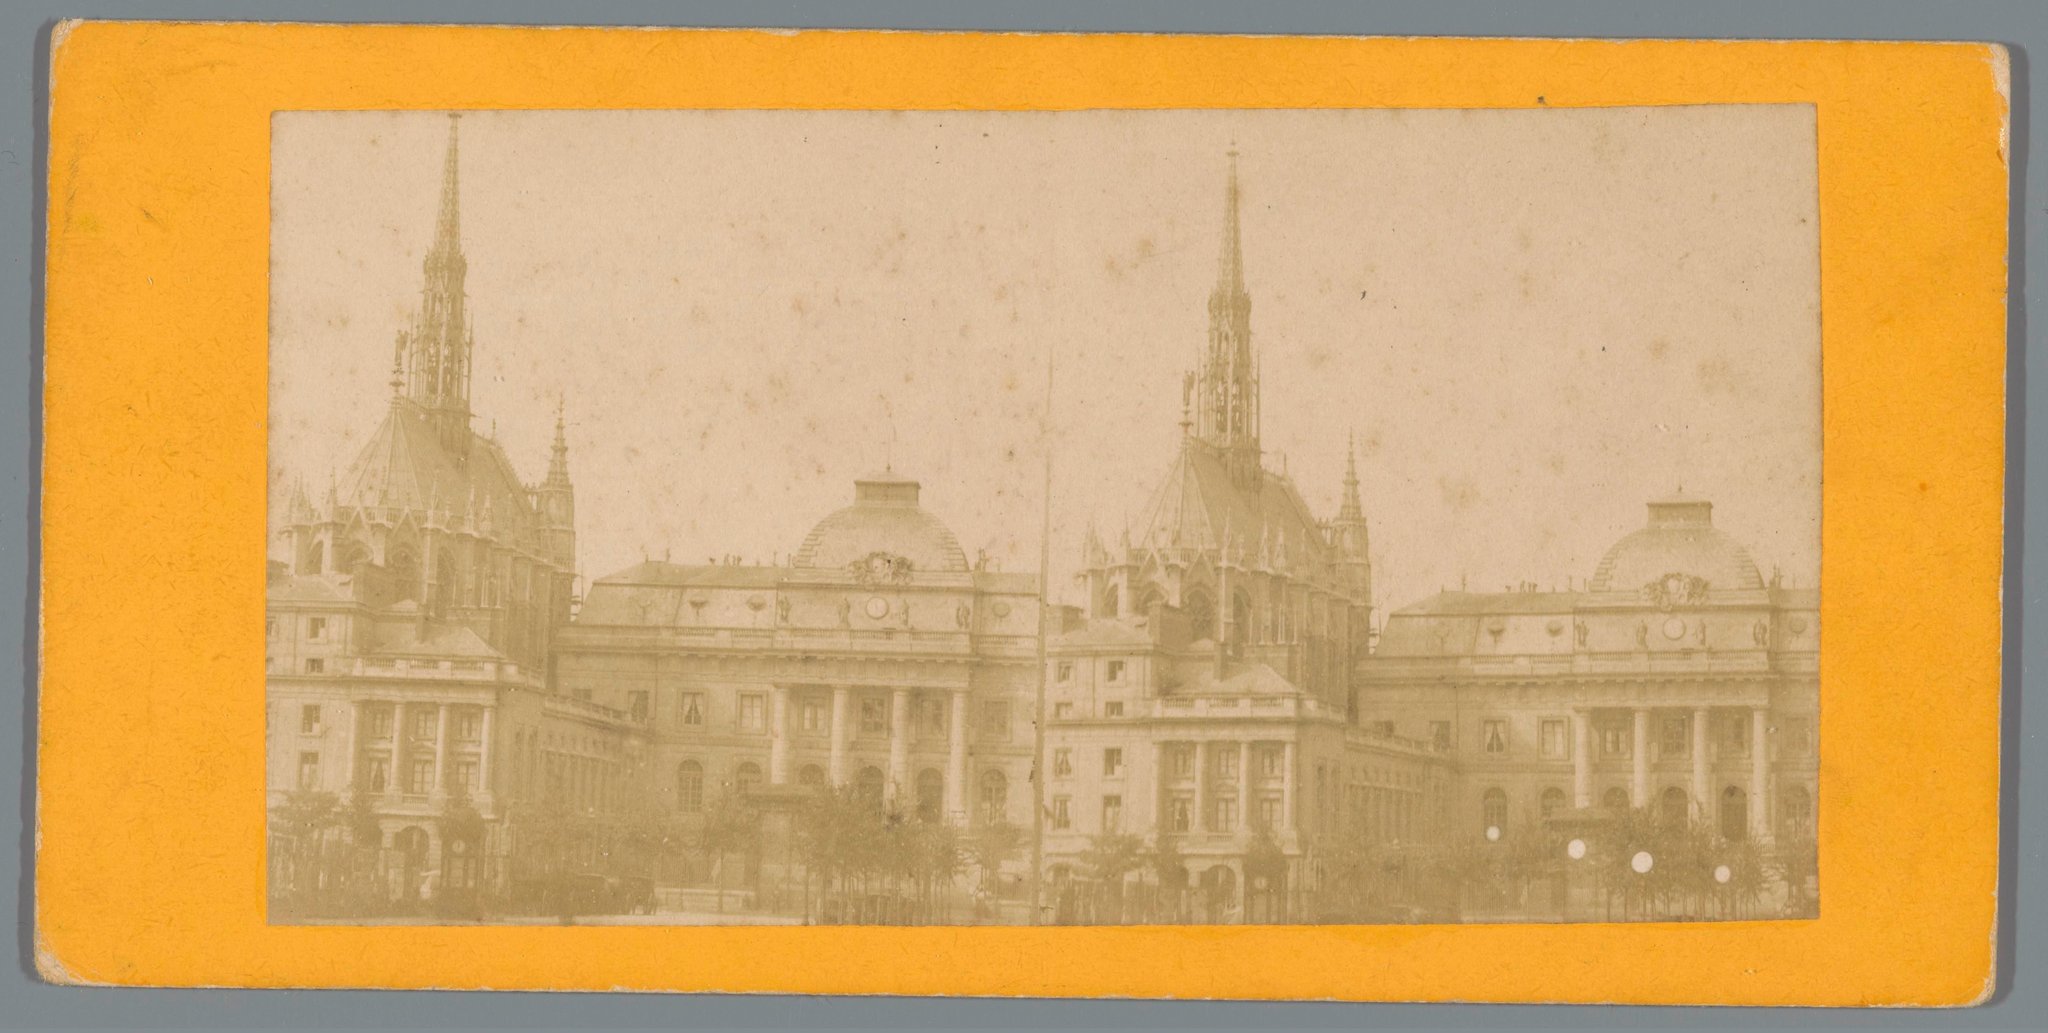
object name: stereograph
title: Gezicht op het Palais de Justice en de Sainte-Chapelle in Parijs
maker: Anonymous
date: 1850-1880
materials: cardboard, photographic support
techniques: albumen print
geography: paris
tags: court building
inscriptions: inscription: ‘Palais de Justice et Ste Chapelle Paris’